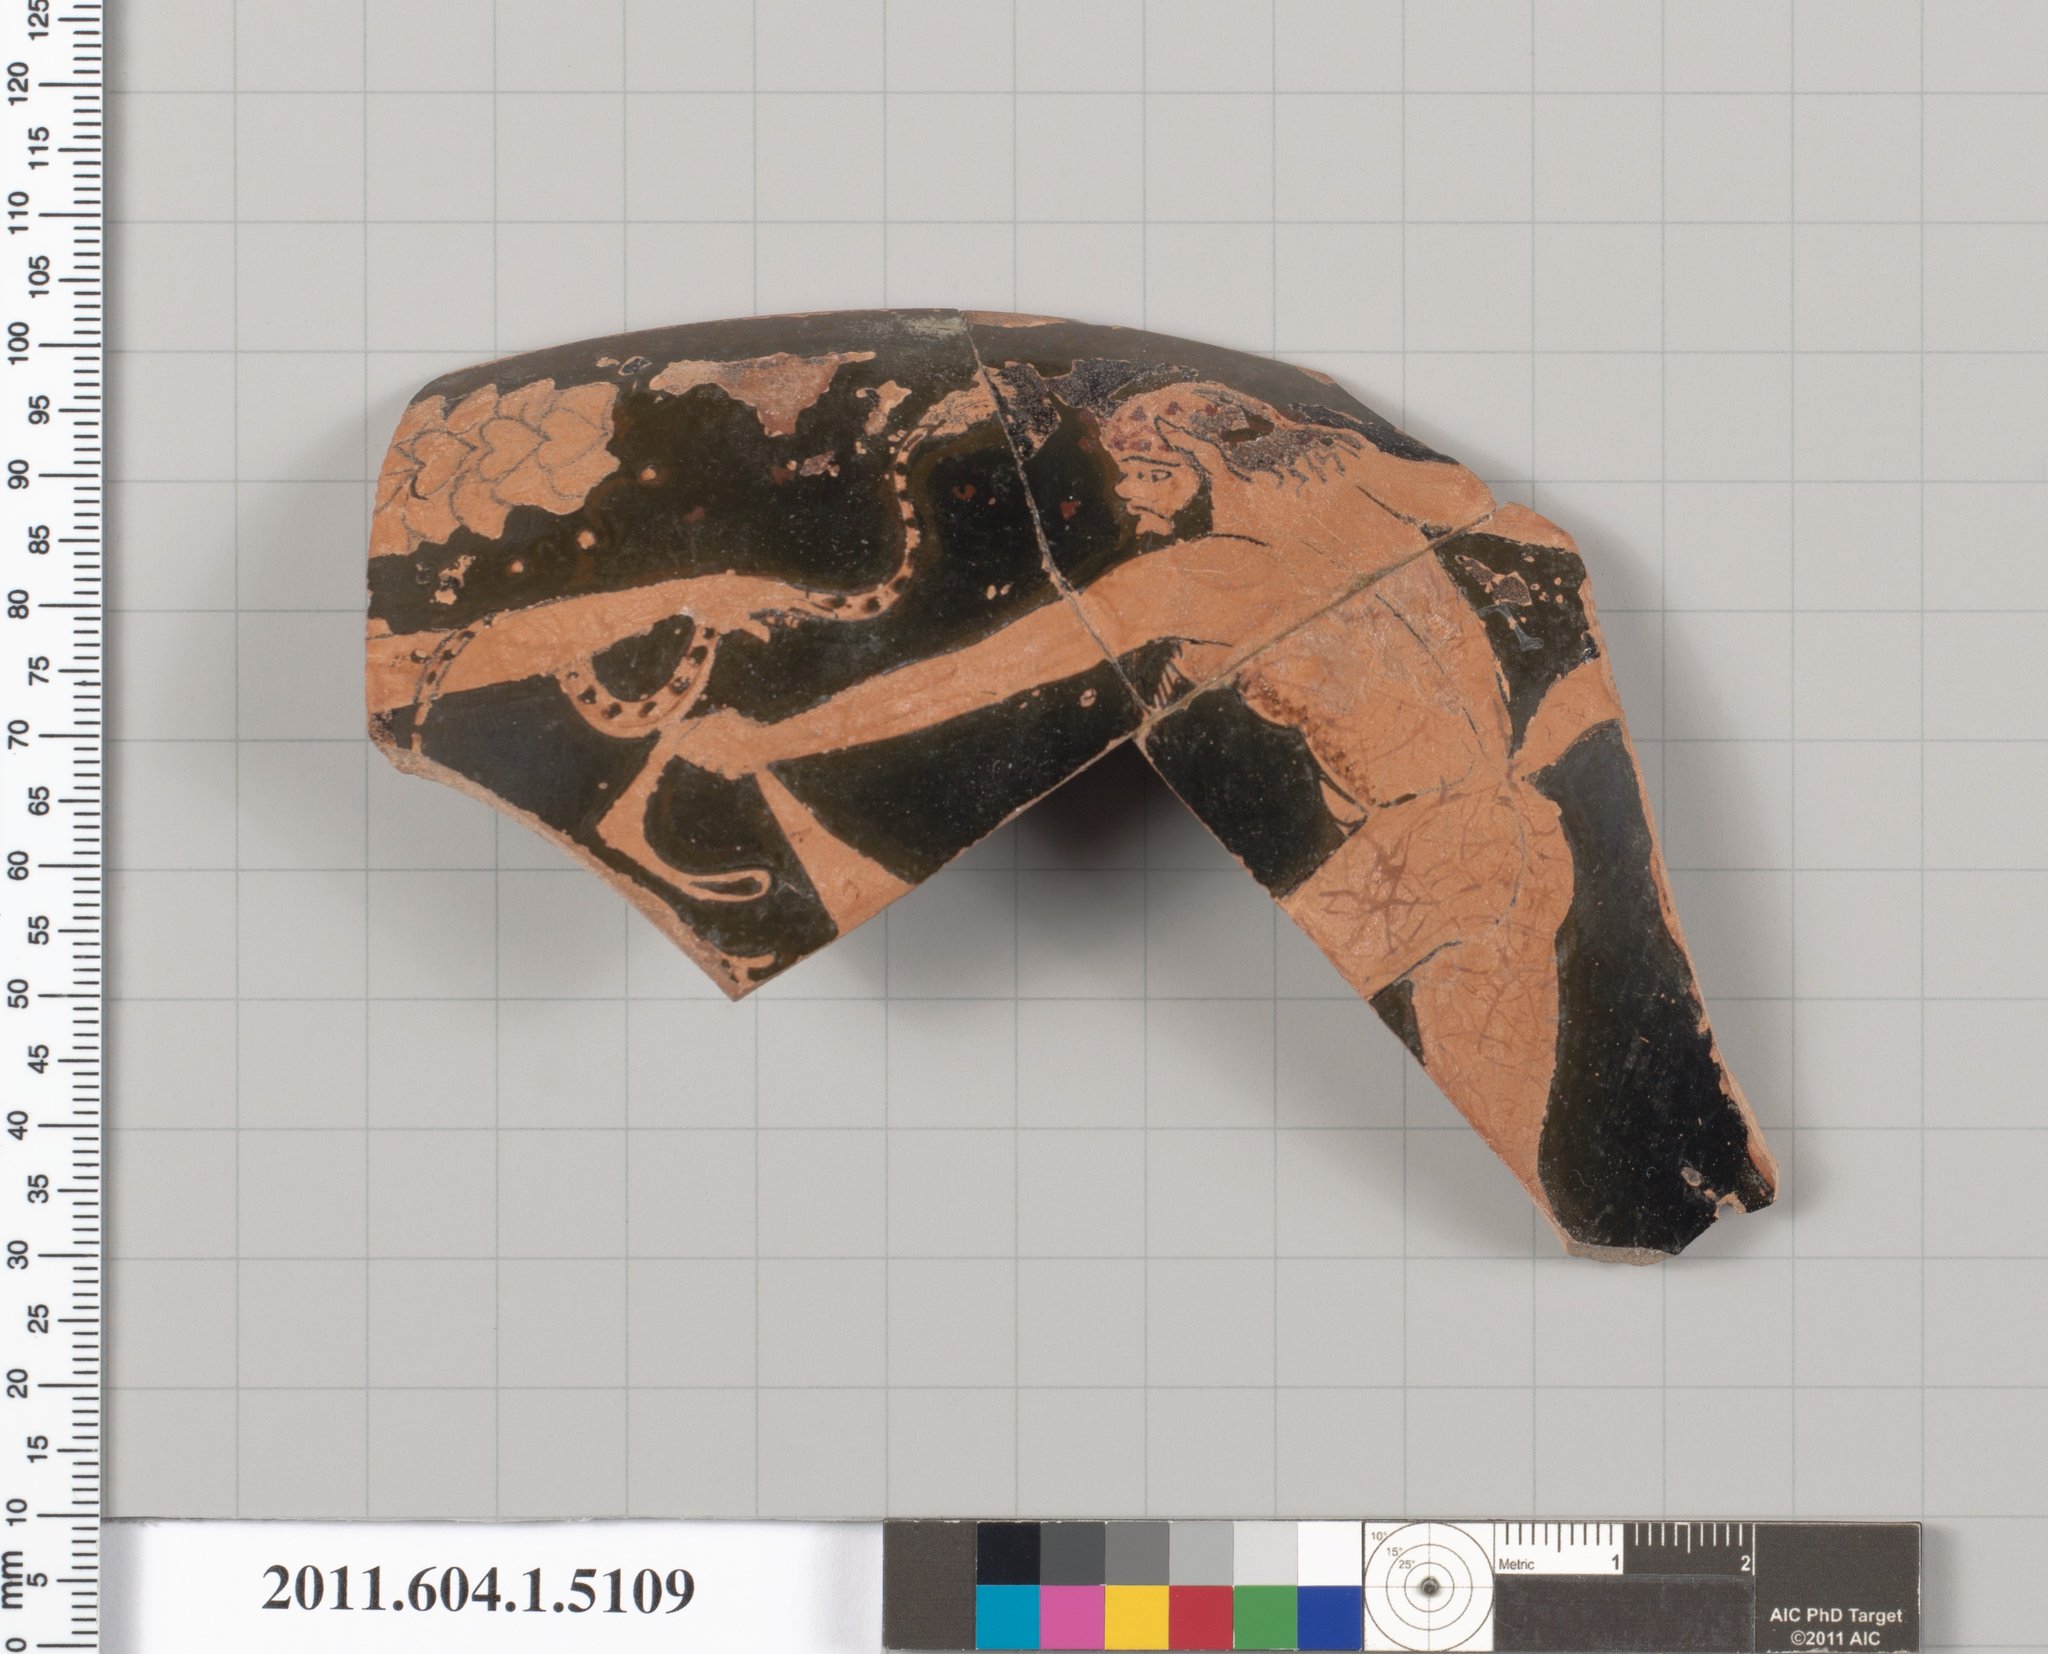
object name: kylix fragment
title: Terracotta rim fragment of a kylix (drinking cup)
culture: greek, attic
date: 510-490 BCE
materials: terracotta